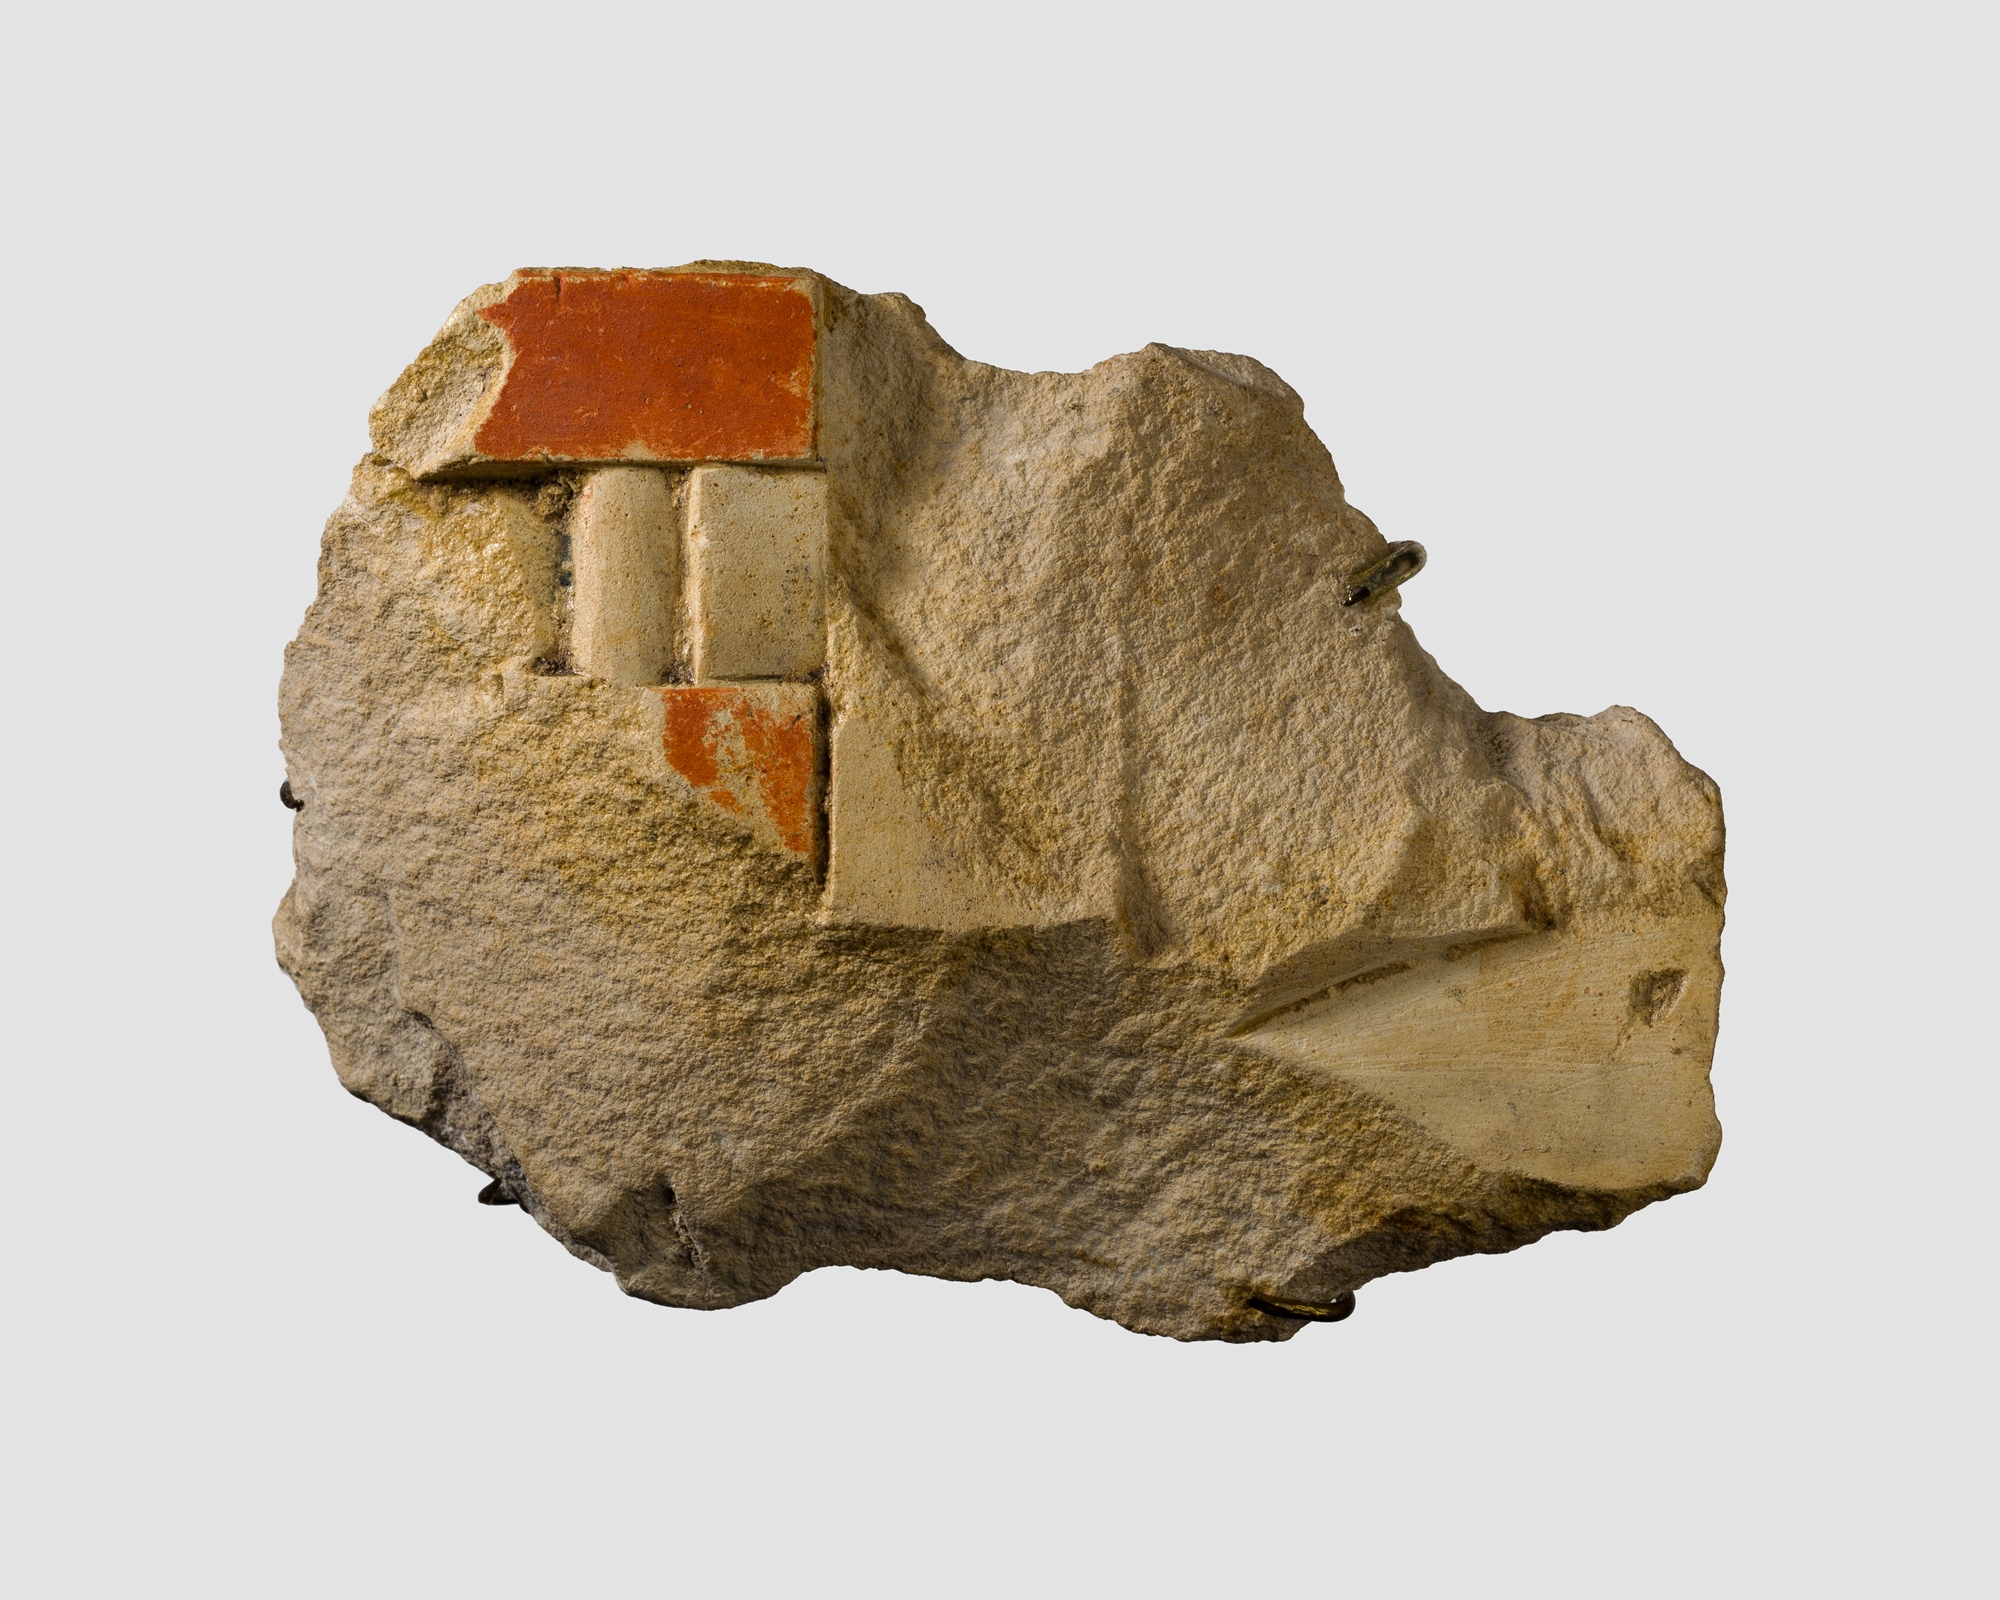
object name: relief fragment, neferu or khety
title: Relief fragment probably from the tomb of Khety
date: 2030-1640 BCE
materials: limestone, paint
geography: egypt